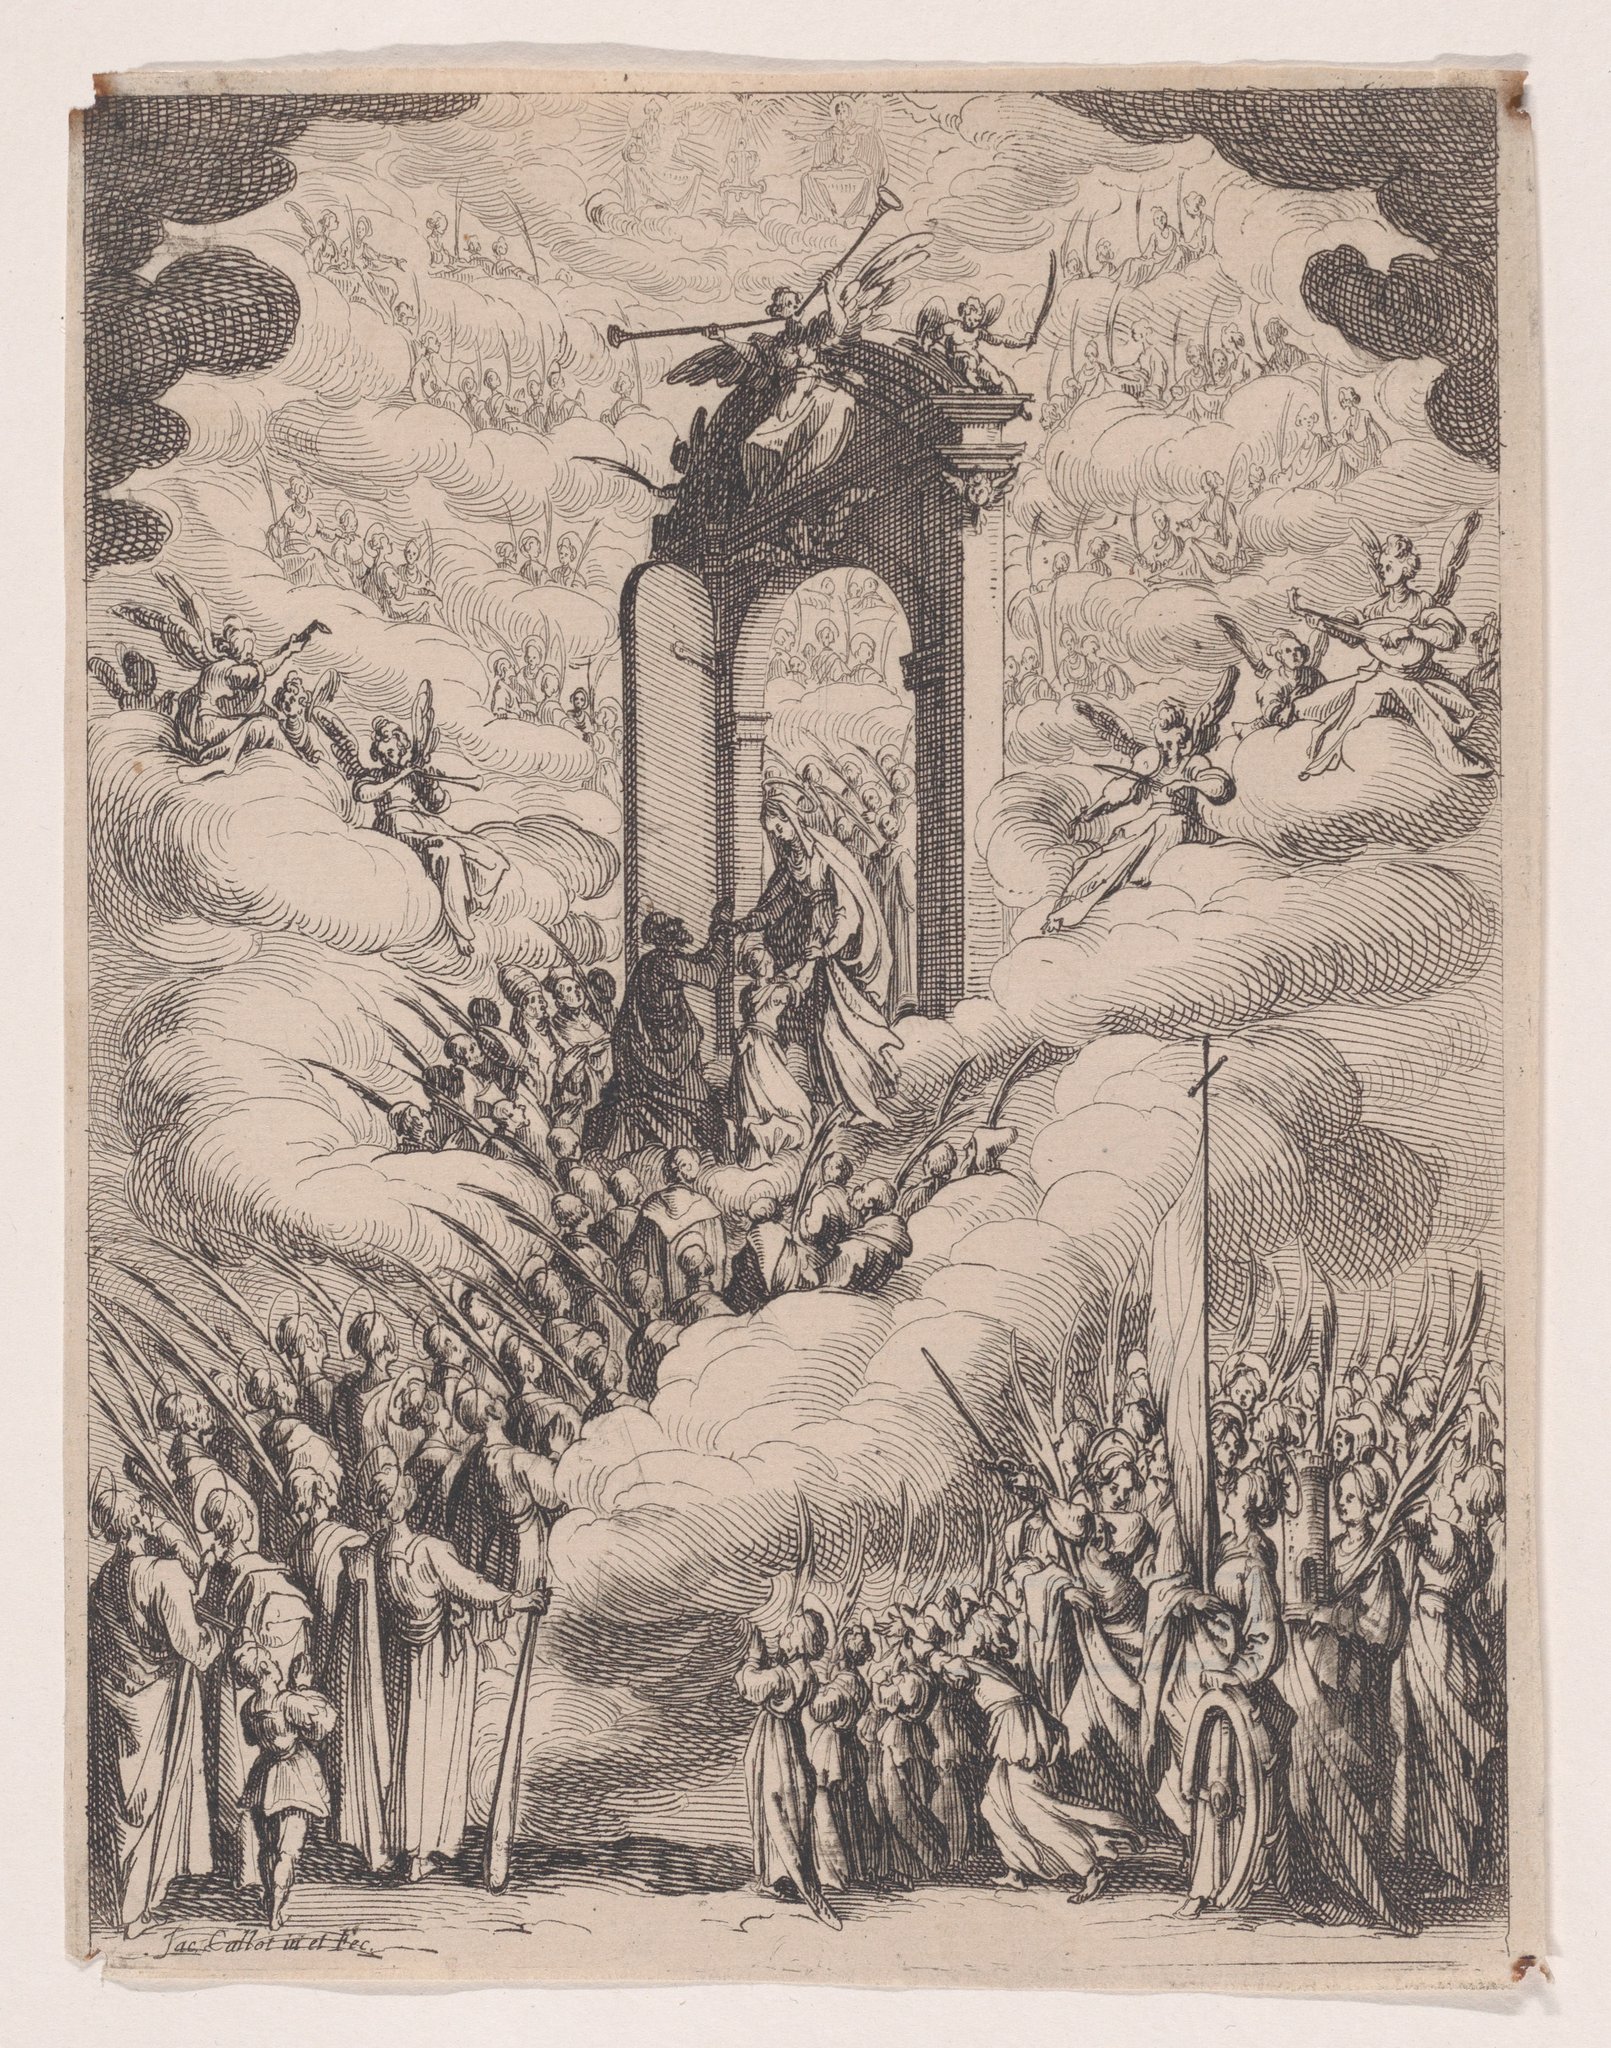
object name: print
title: Frontispiece, from "Les Images De Tous Les Saincts et Saintes de L'Année" (Images of All of the Saints and Religious Events of the Year)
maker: jacques callot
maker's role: artist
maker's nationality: french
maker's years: 1592-1635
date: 1632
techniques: etching